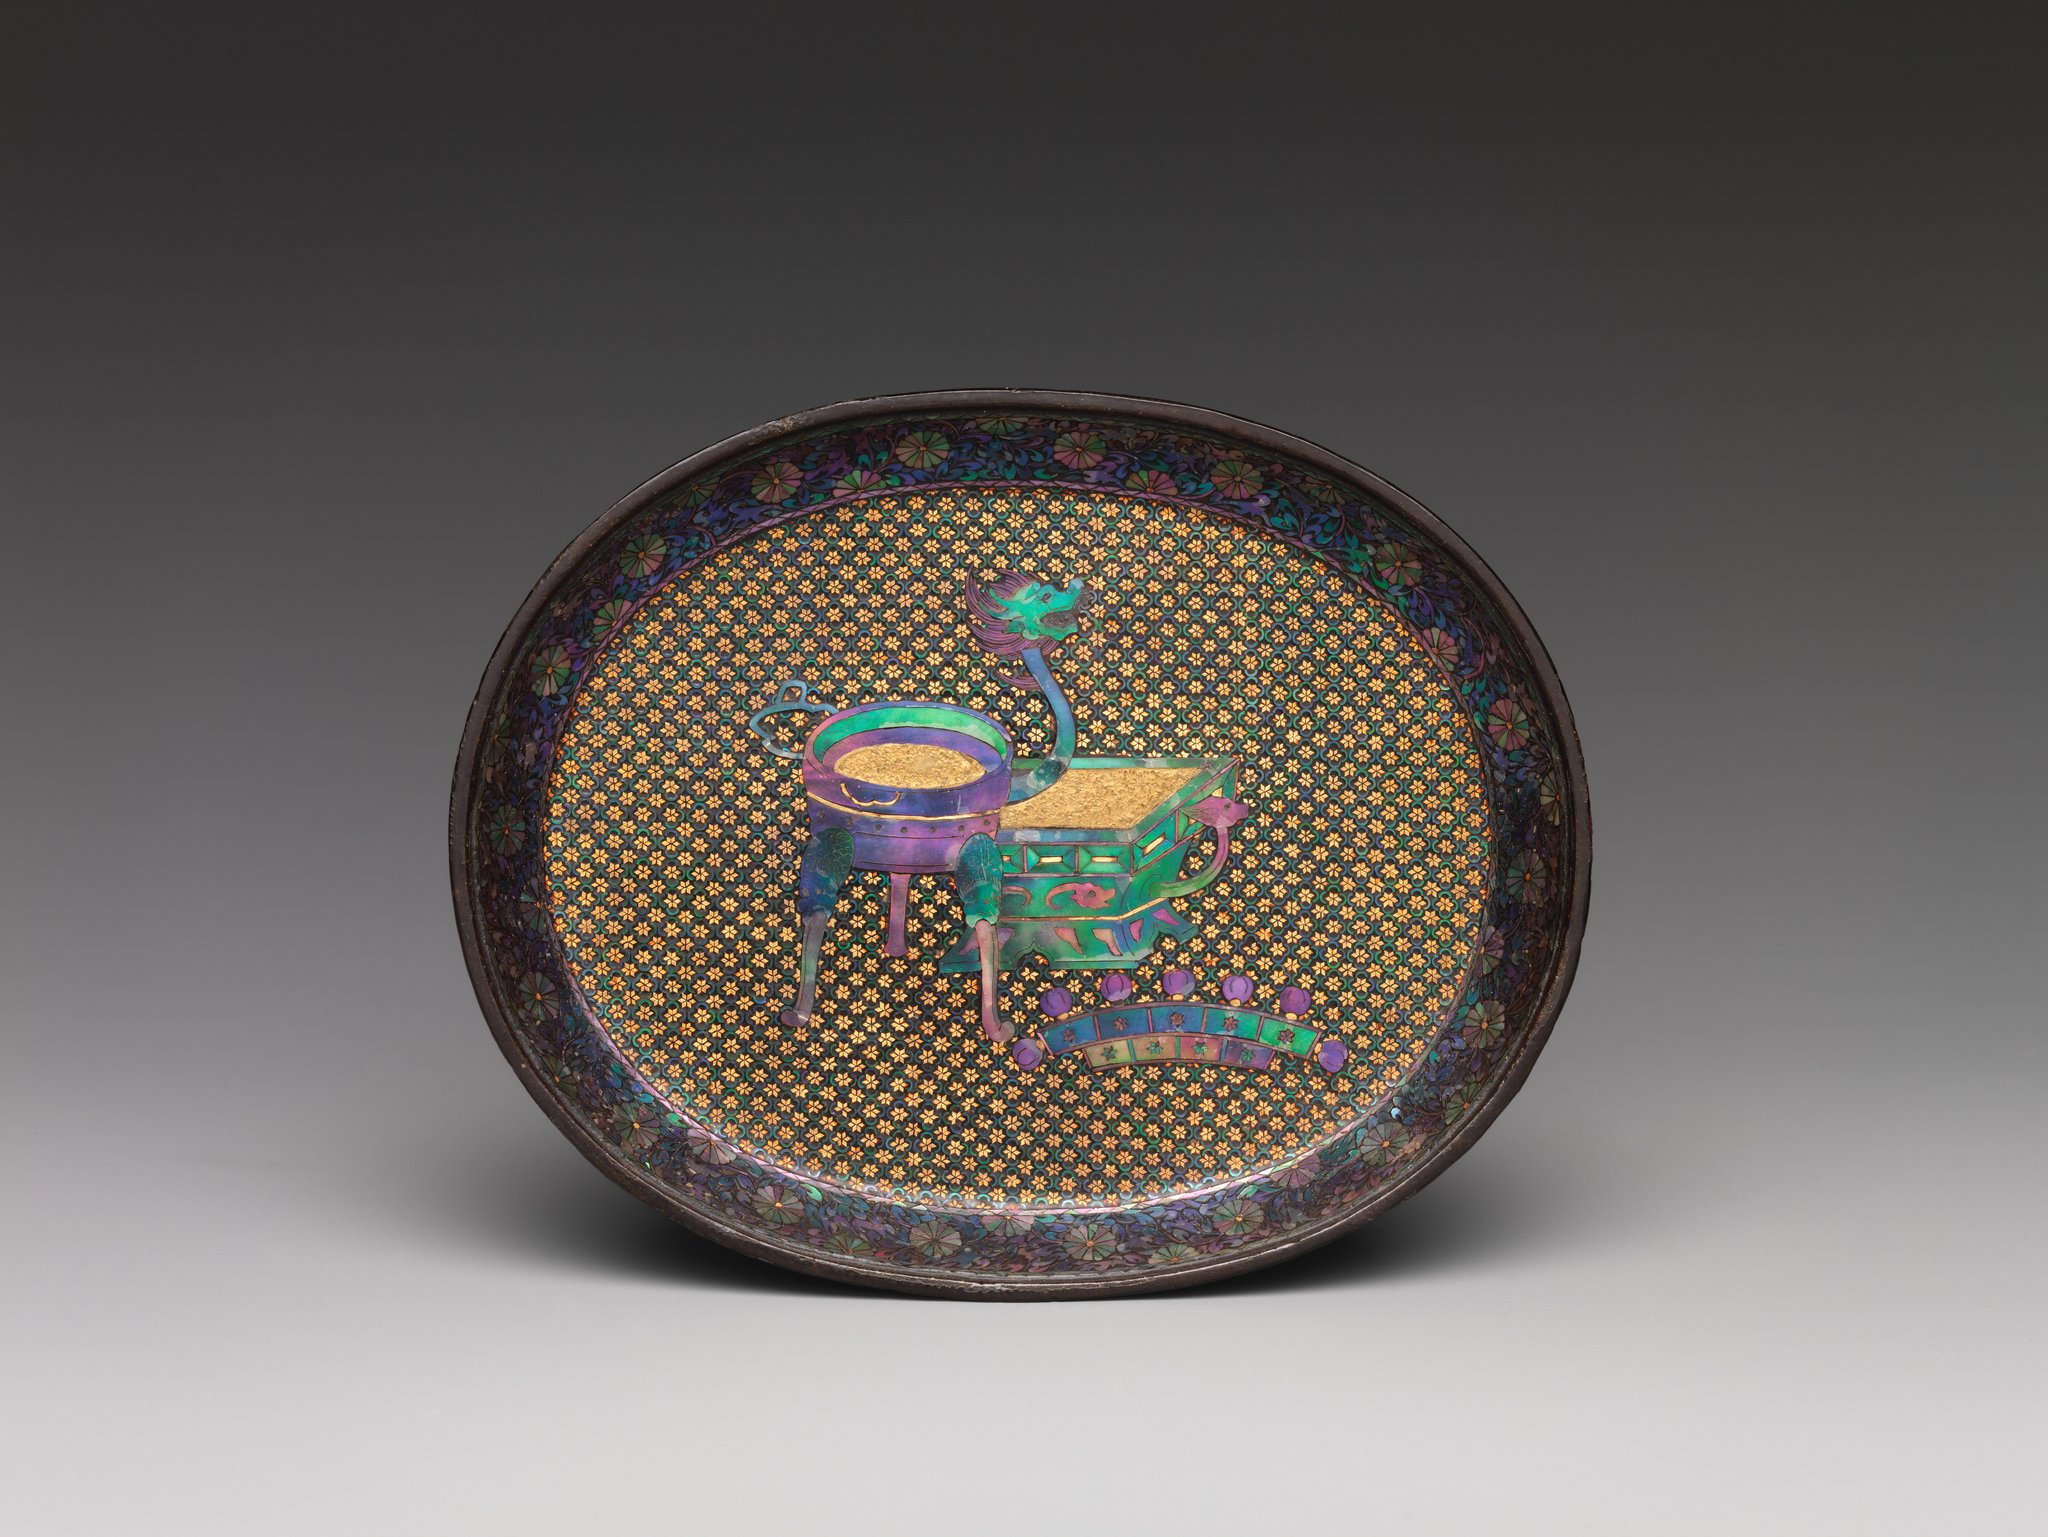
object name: dish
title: Dish with Antiquities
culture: chinese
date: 1634-1733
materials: lacquer, mother of pearl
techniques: inlay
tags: flowers